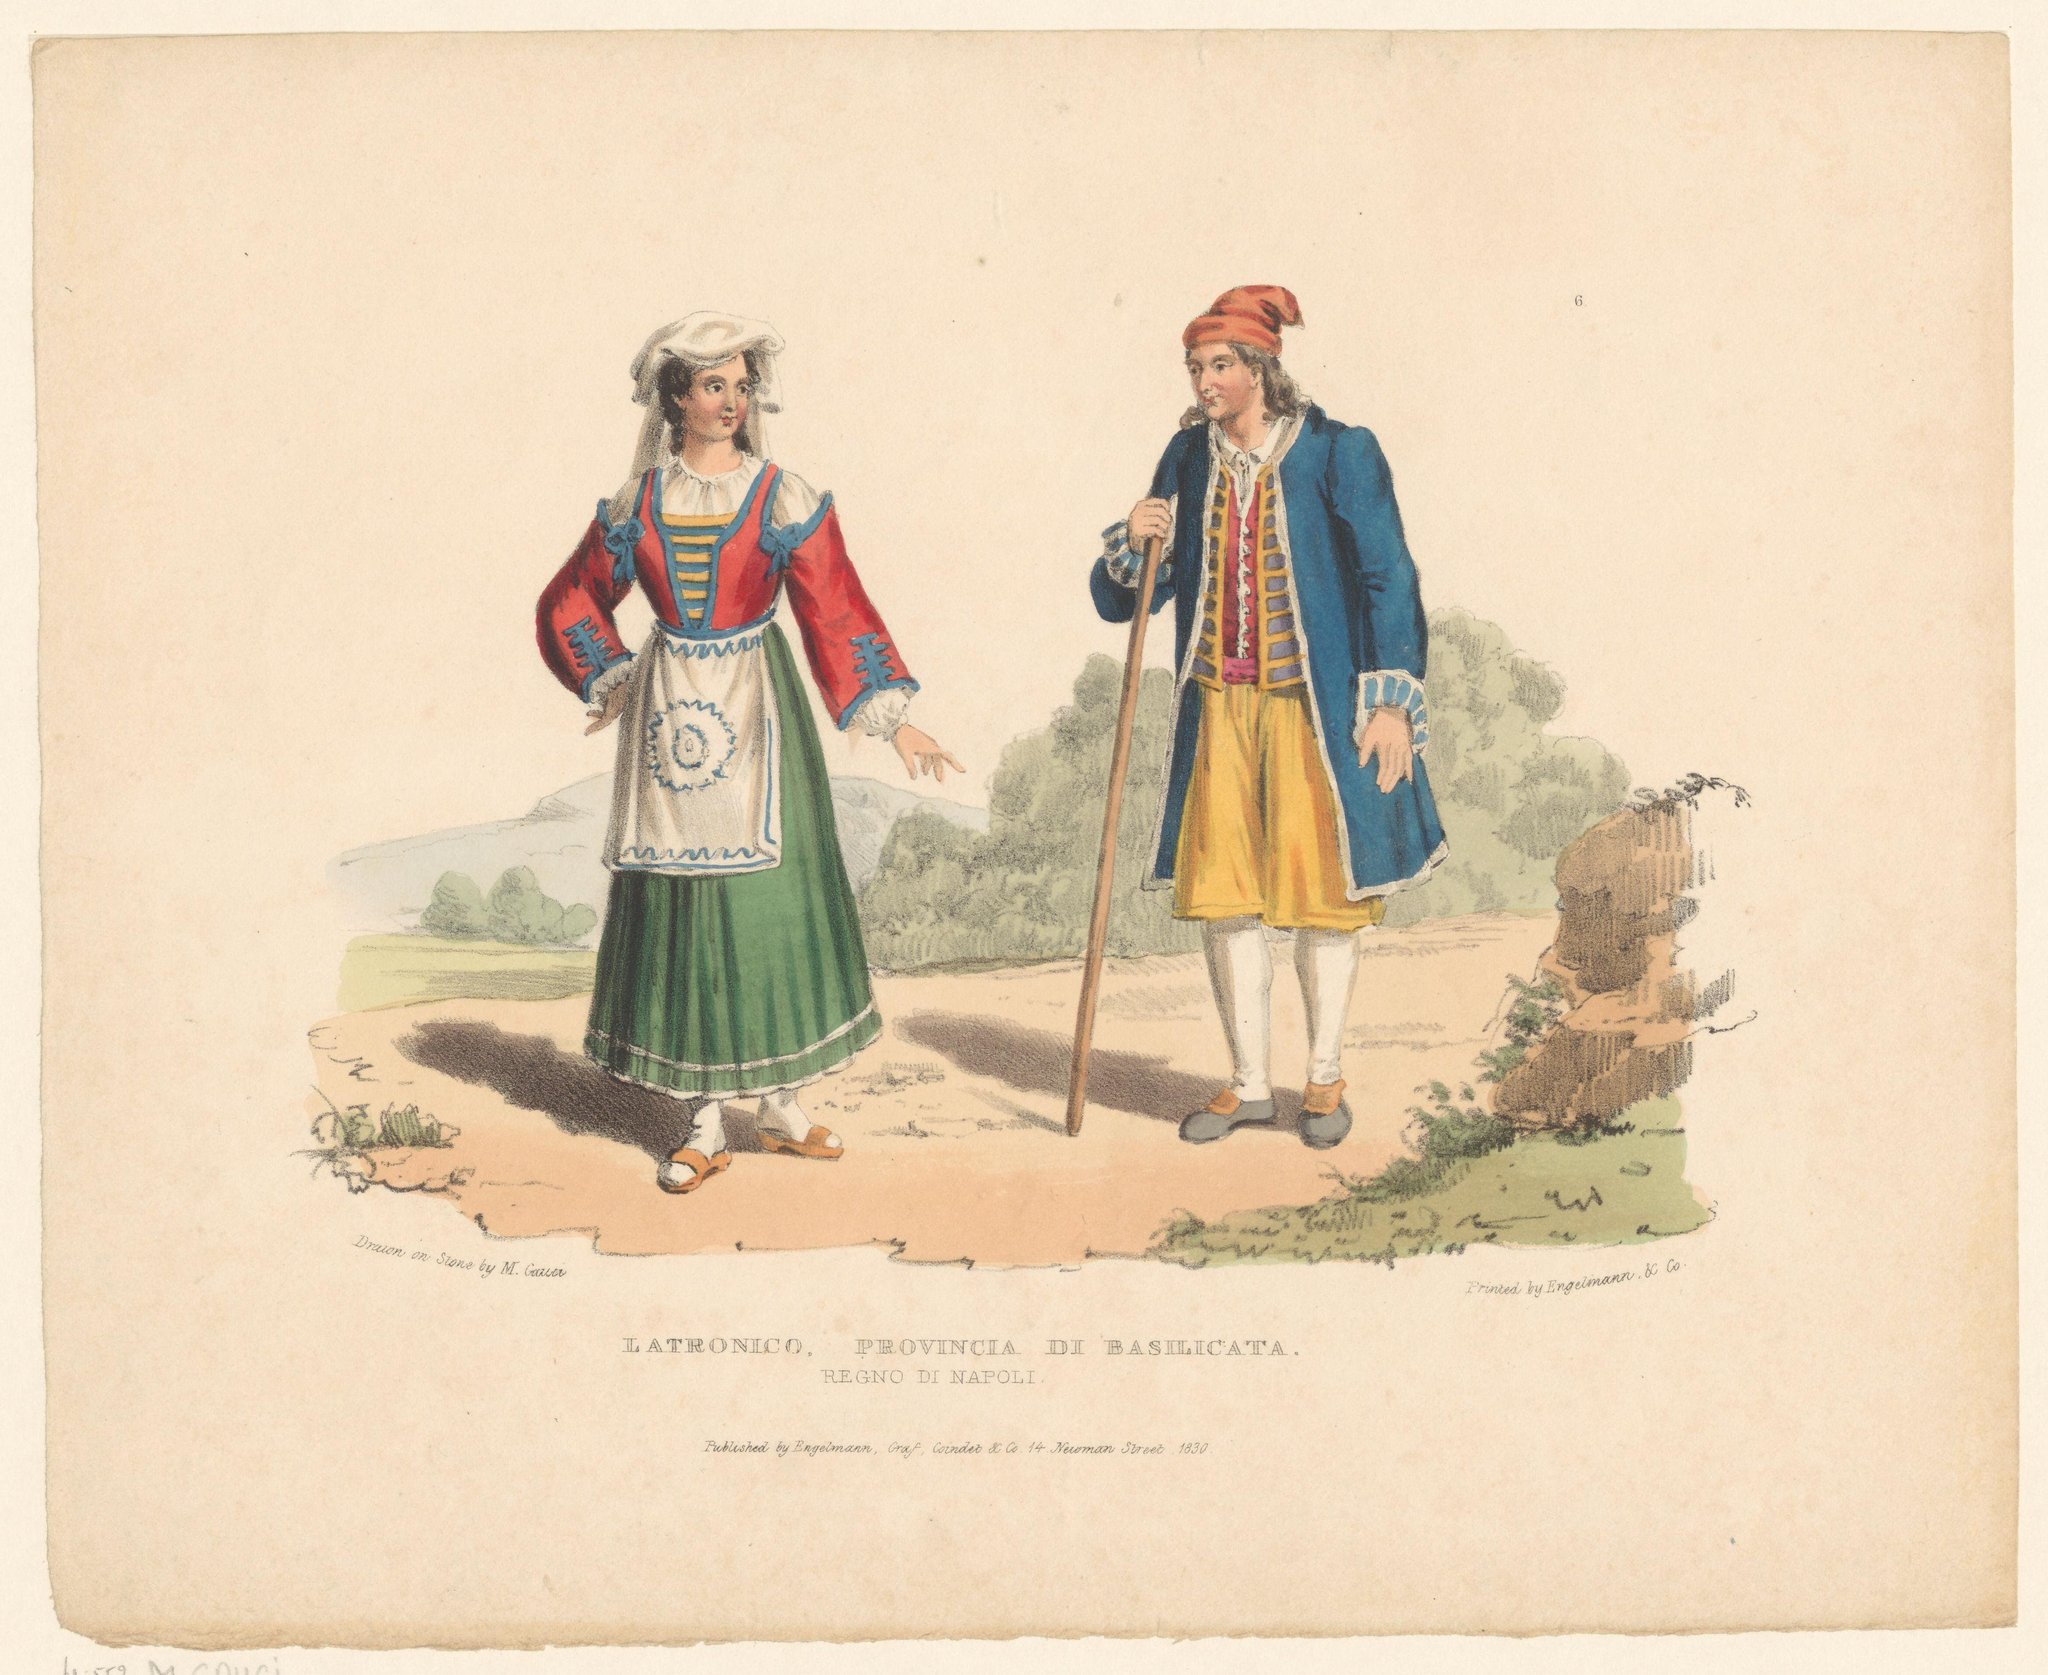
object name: print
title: Latronico, provincia di Basilicata, regno di Napoli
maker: maxim gauci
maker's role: print maker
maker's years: 1774-1854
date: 1830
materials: paper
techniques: hand coloring, lithograph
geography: london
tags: adult woman, adult man, folk costume, regional costume, europeans (with name)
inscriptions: collector's mark: Lugt 2228, mark: ‘School voor de grafische vakken te Utrecht’